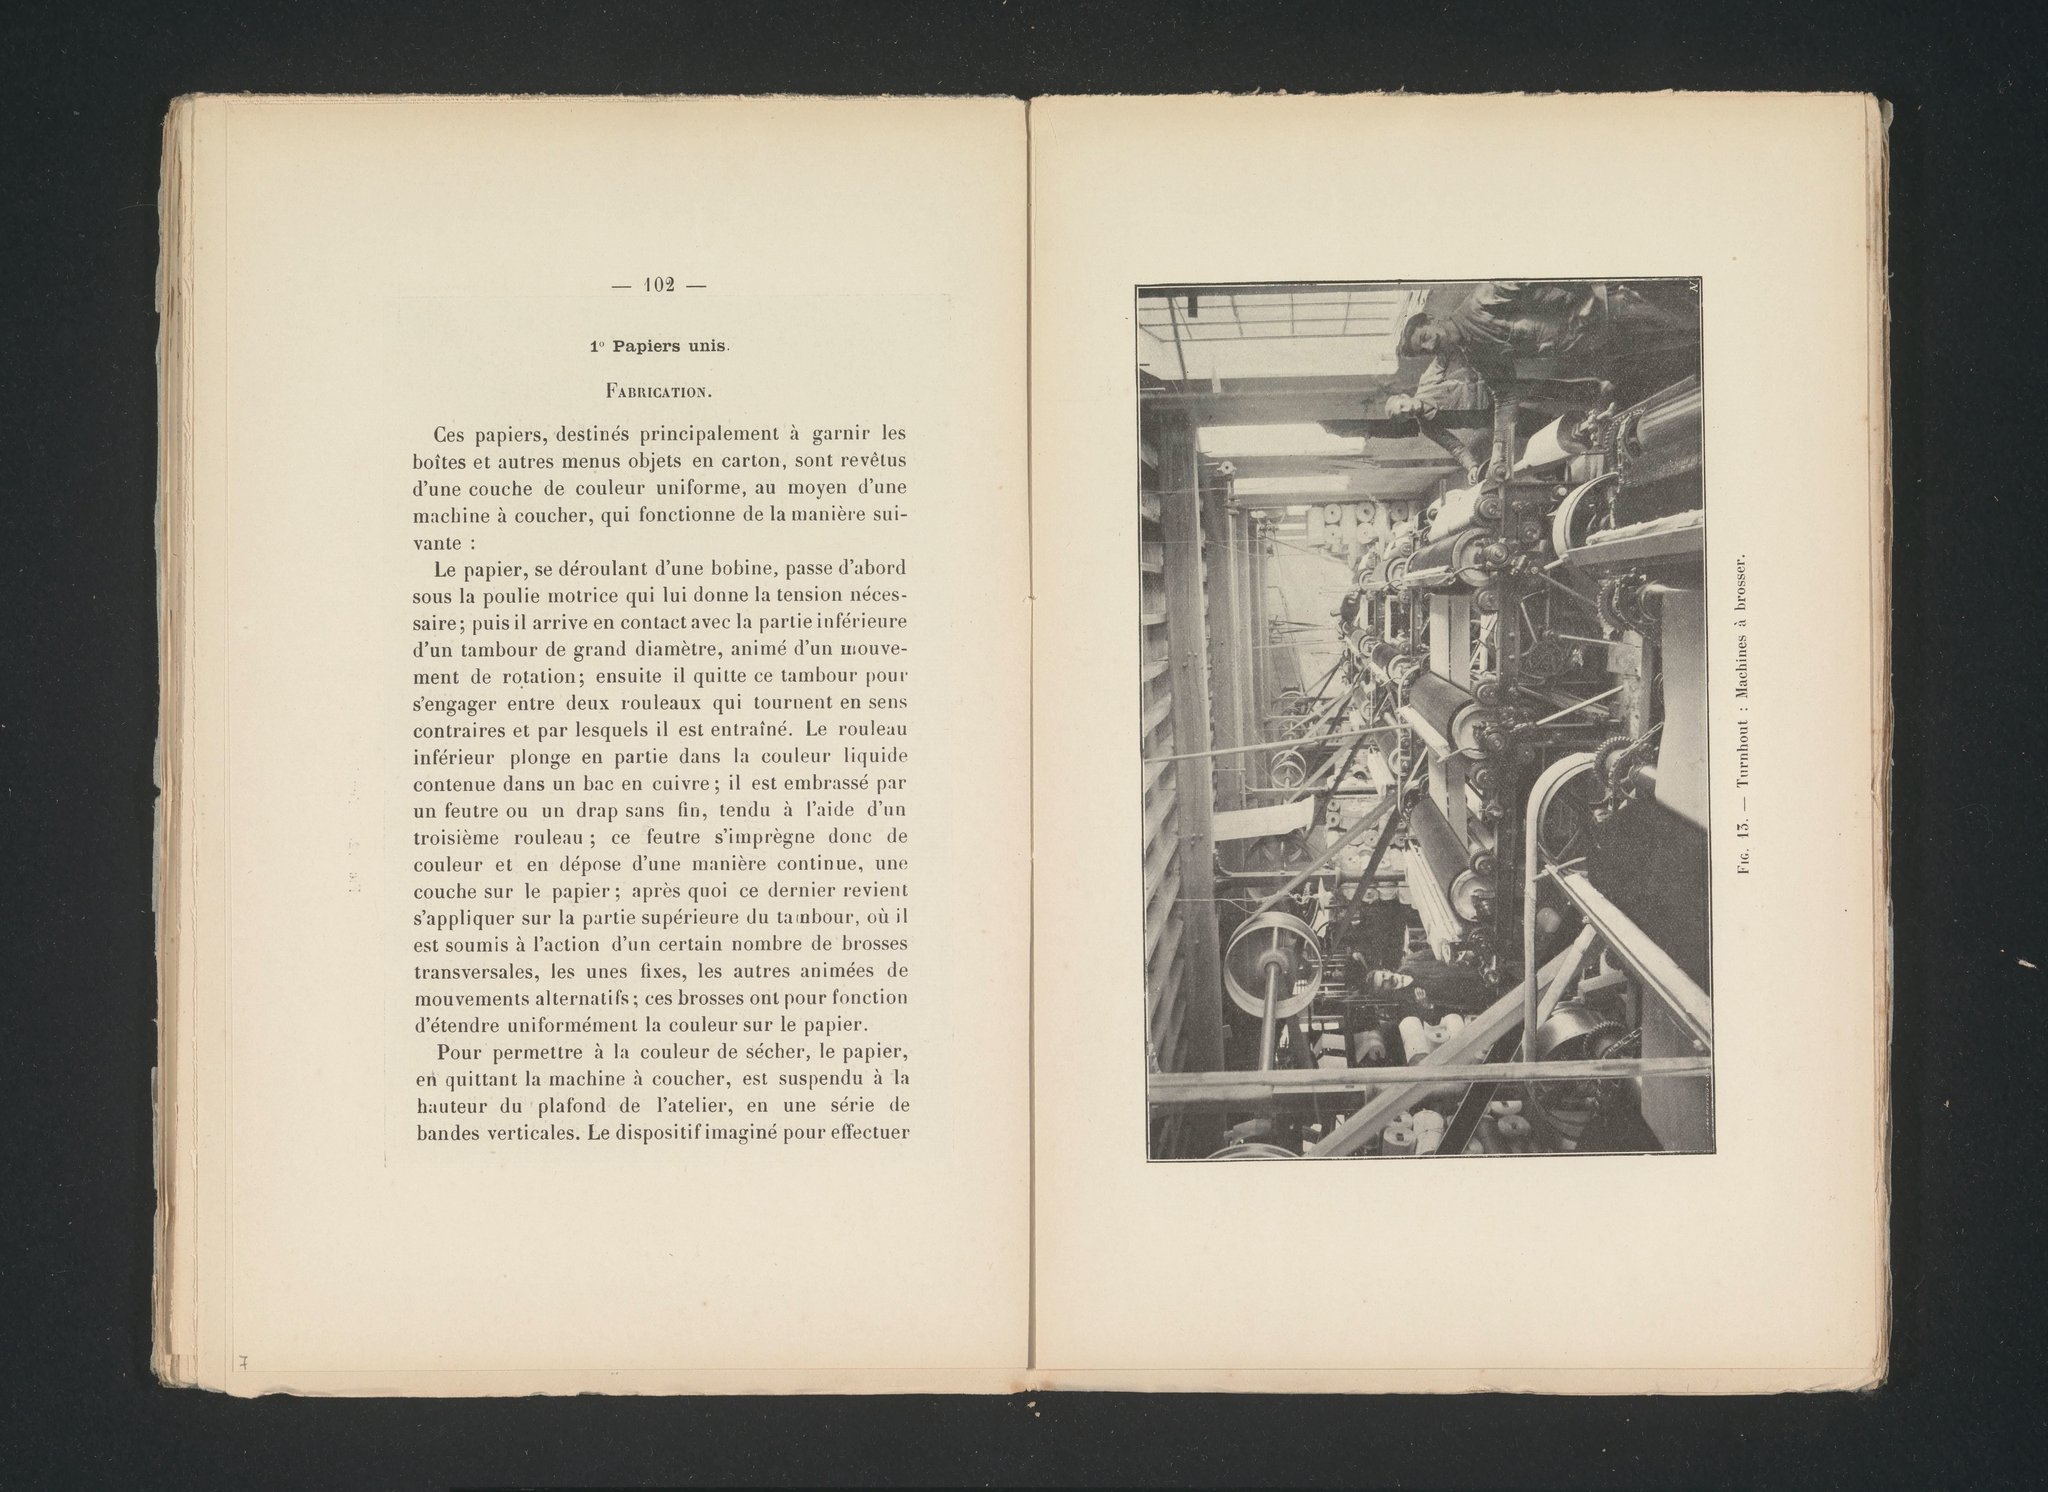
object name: page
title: Gezicht op een werkplaats met borstelmachines in een papierfabriek in Turnhout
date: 1901-1906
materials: paper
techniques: autotype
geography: turnhout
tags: machine driven by electricity, paper (writing material), workshop-interior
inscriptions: inscription: ‘Fig. 13. - Turnhout: Machines à brosser.’, monogram: ‘AN’